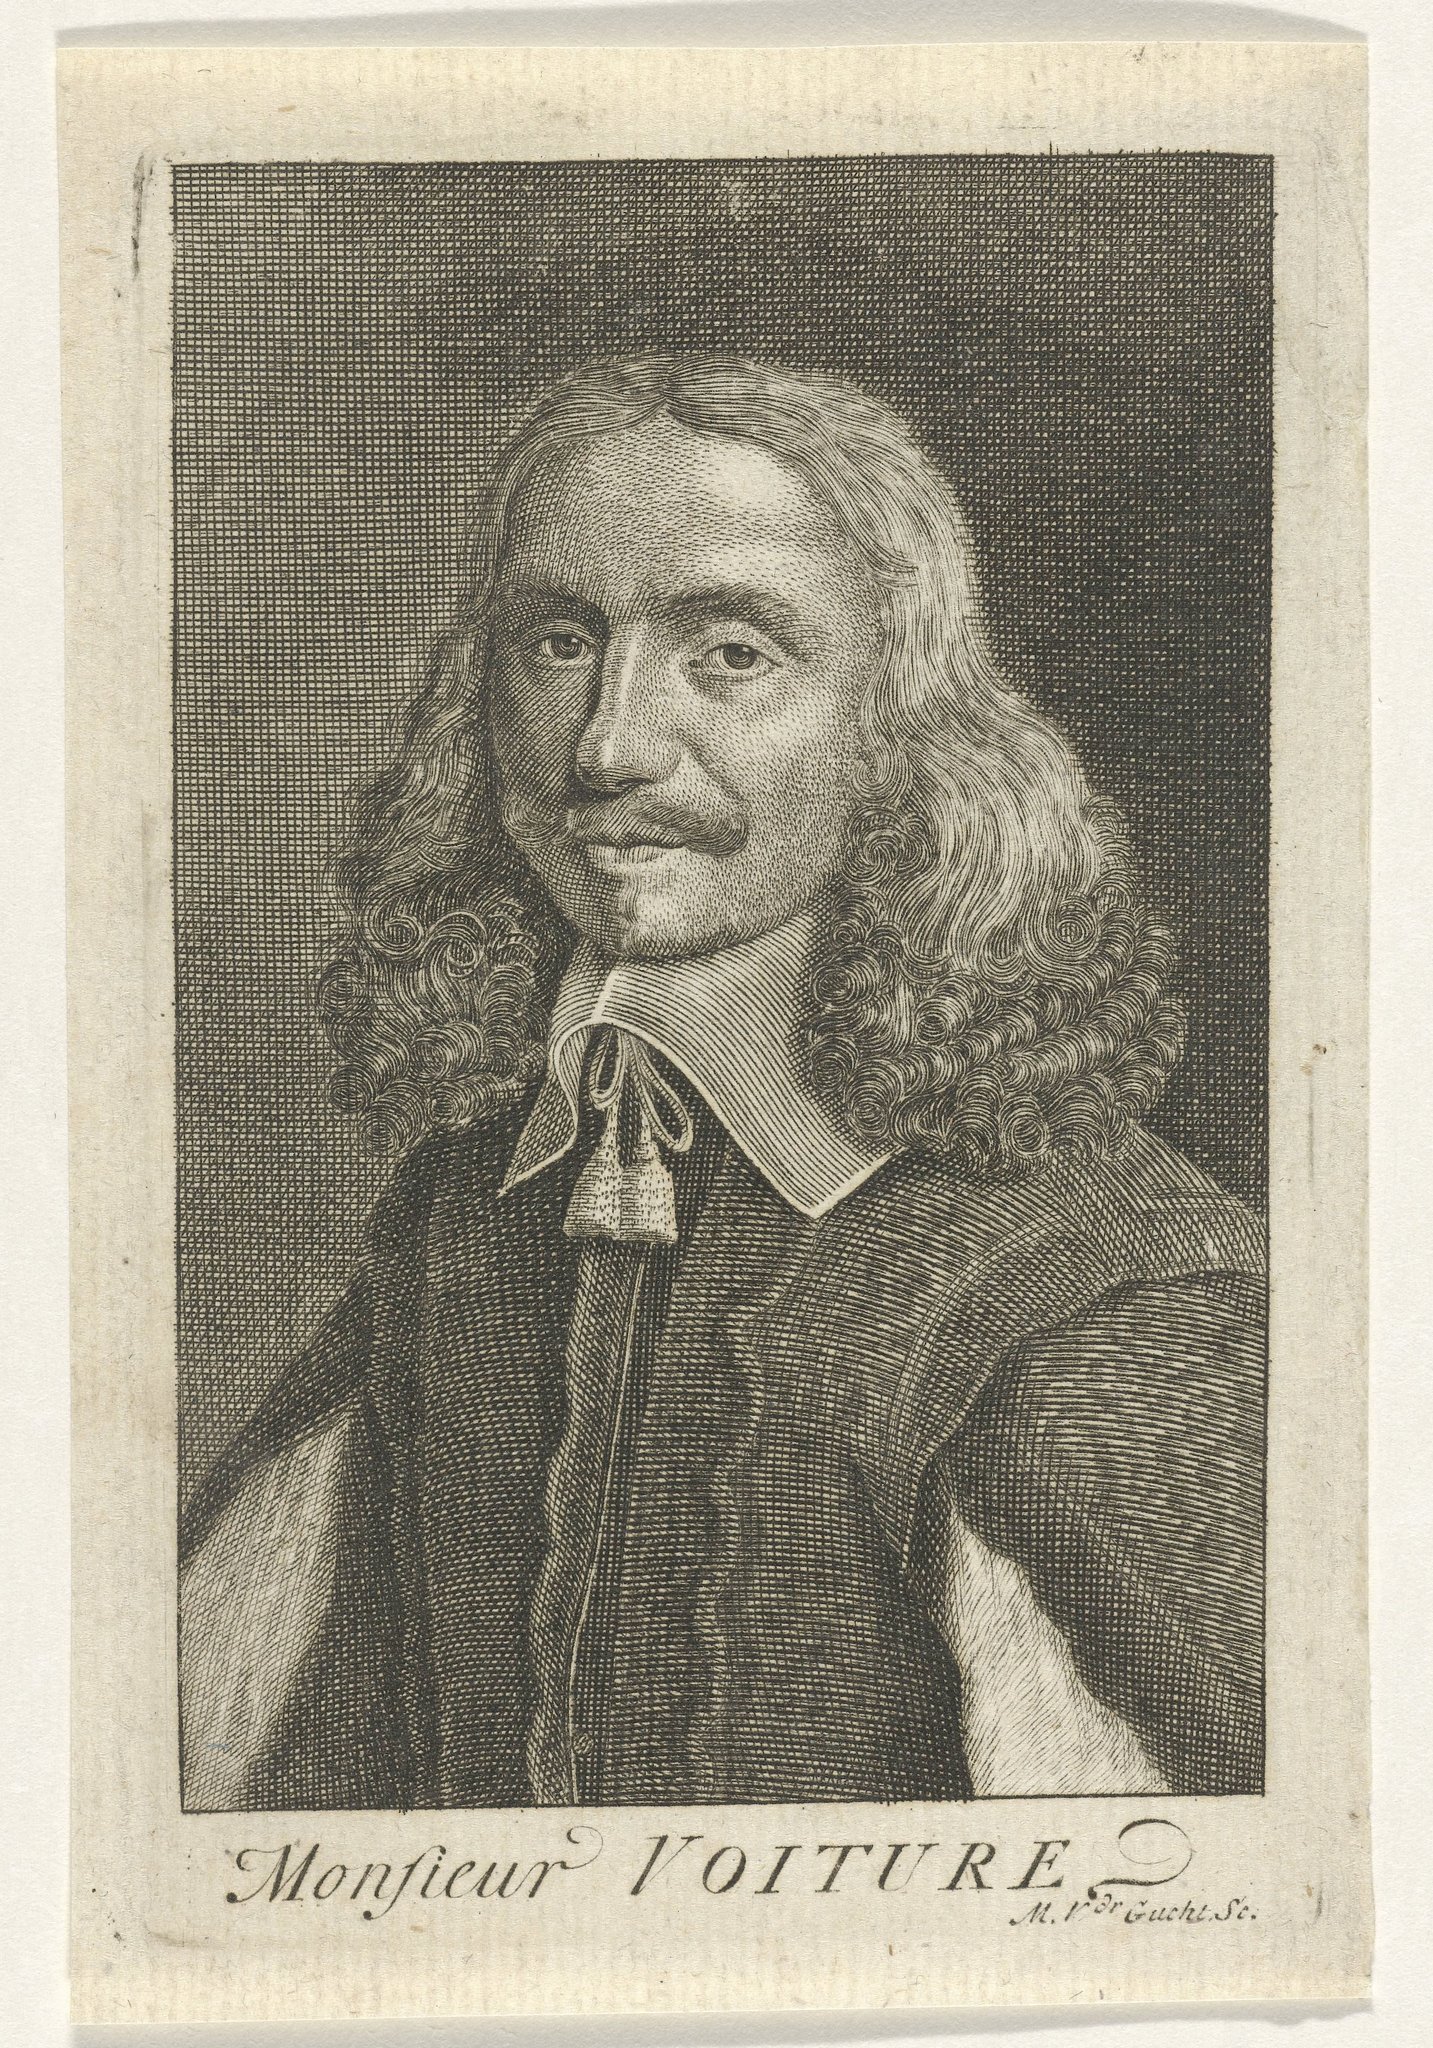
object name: print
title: Portret van monsieur Voiture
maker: michiel van der gucht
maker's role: print maker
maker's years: 1660-1725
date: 1670-1725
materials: paper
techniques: engraving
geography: antwerp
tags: paris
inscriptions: collector's mark: Lugt 2228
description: Busteportret van monsieur Voiture. Onder de voorstelling de naam van de geportretteerde.